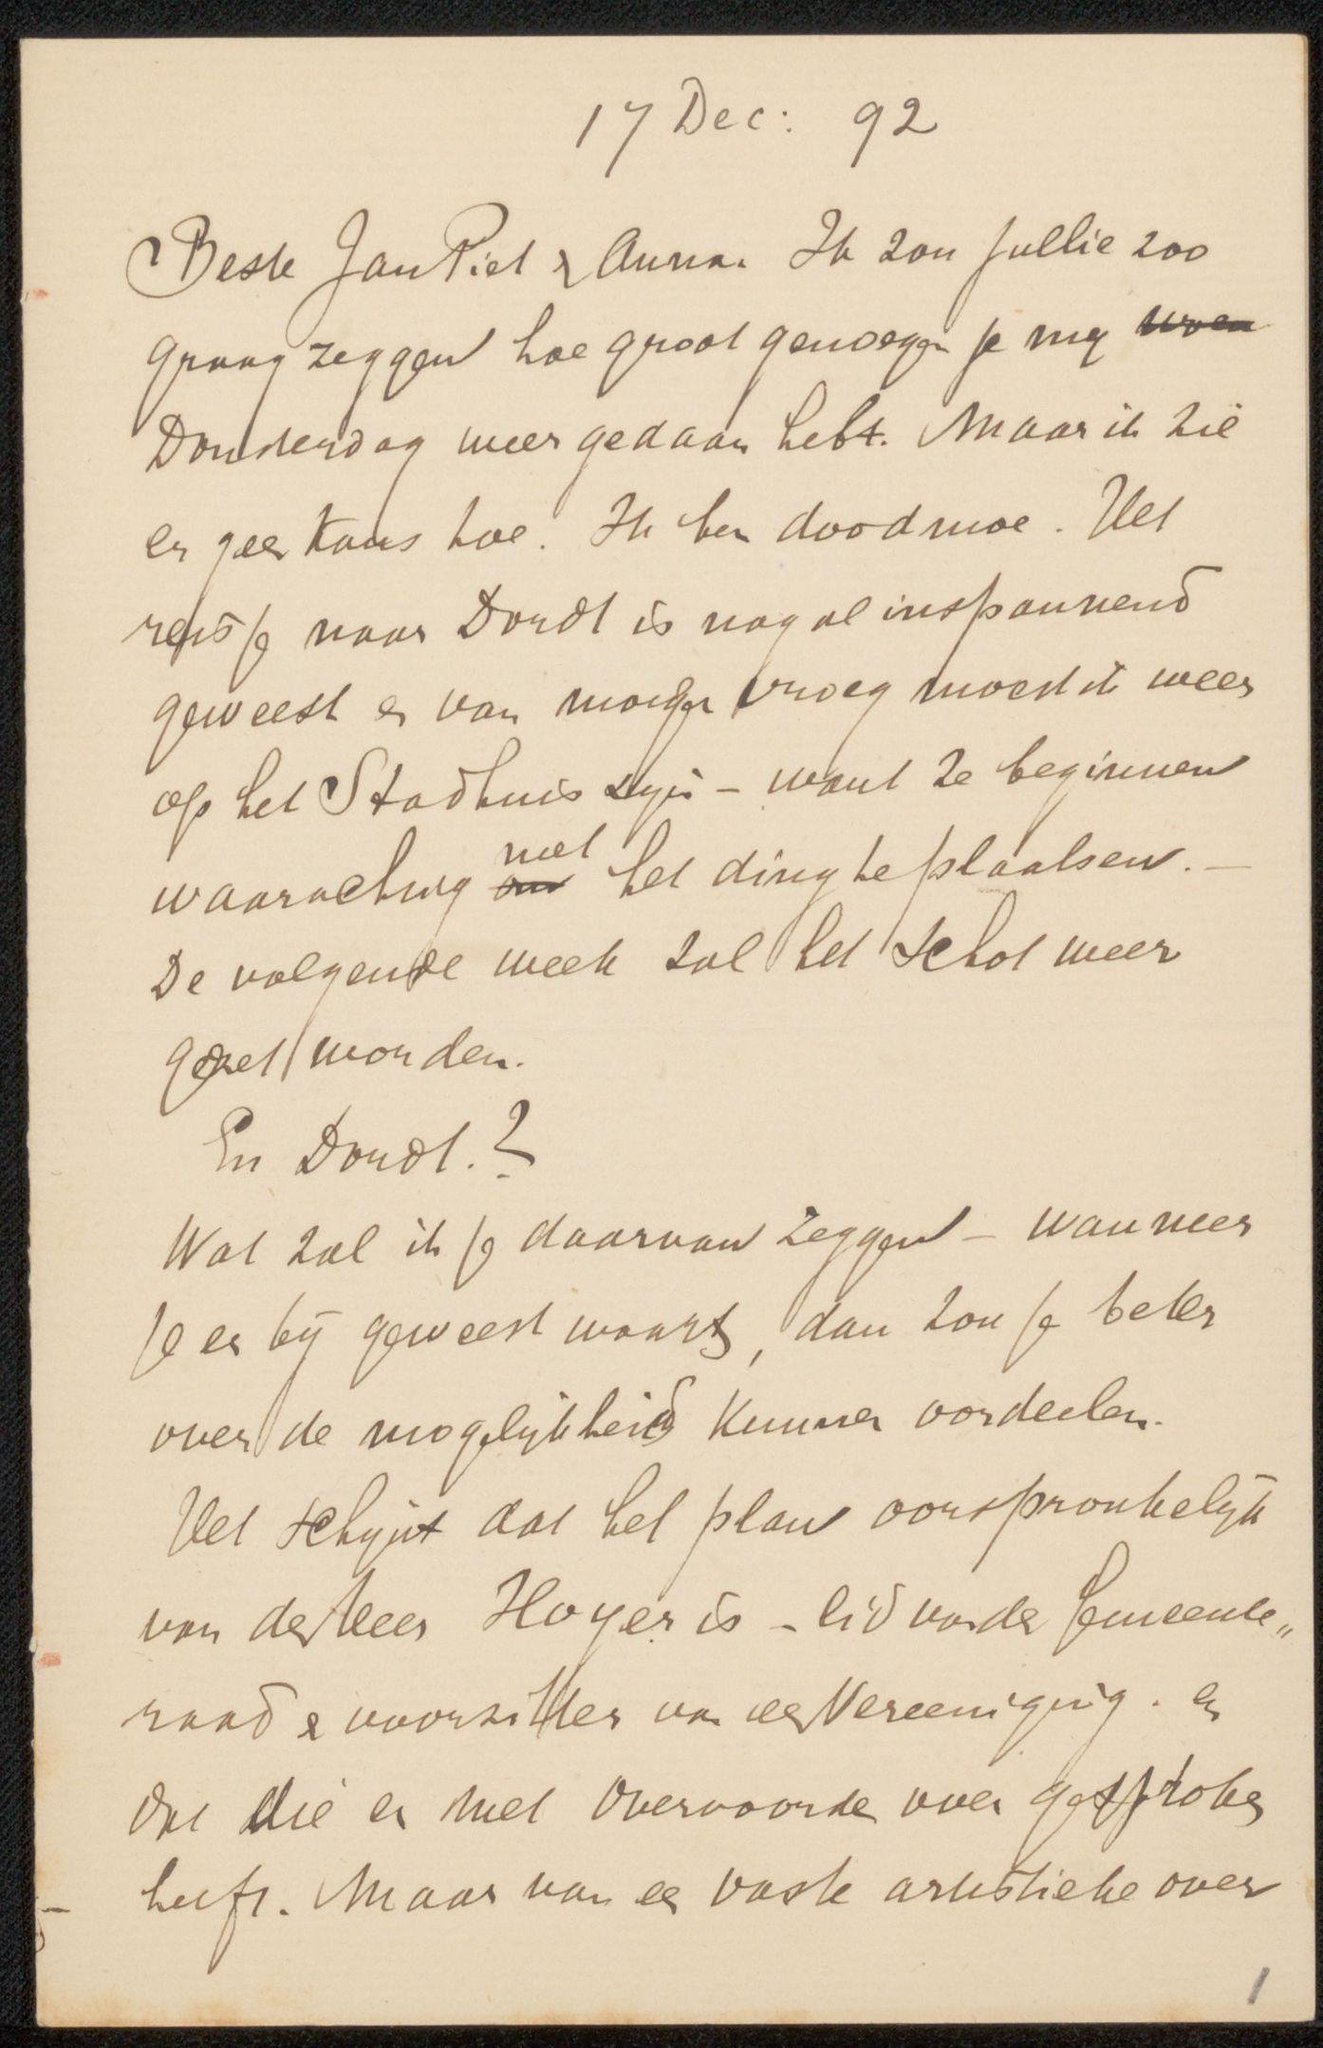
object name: letter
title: Brief aan Jan Veth en Anna Dorothea Dirks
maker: antoon derkinderen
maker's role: draughtsman, painter, print maker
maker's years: 1859-1925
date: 1874-1925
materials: ink, paper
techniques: pen, writing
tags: dordrecht, amsterdam, painter, print maker, draughtsman, designer, jan veth, artist, anna dorothea dirks, painting (including book-illumination, miniature-painting)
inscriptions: collector's mark: ‘RPK’, watermark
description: Brief gedateerd 17 Dec: 92 in latere hand.